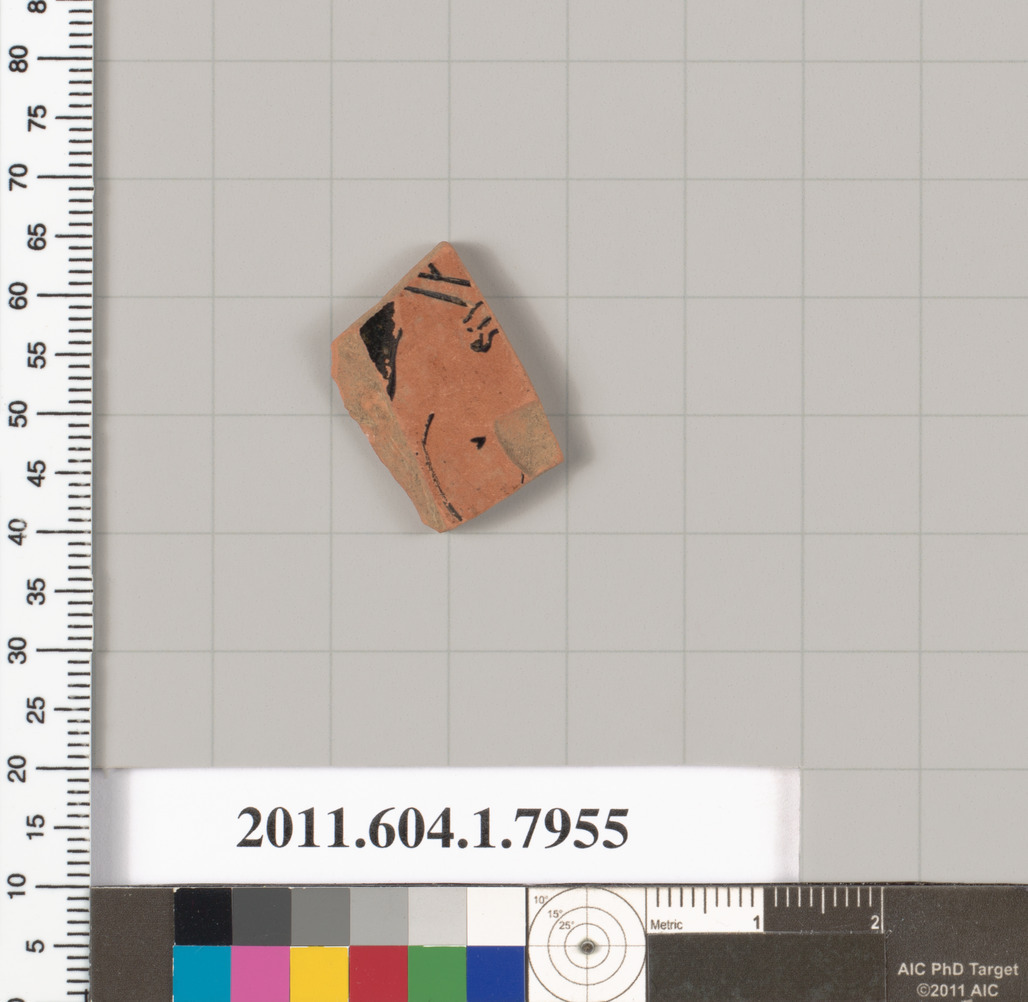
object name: kylix fragment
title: Terracotta fragment of a kylix (drinking cup)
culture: greek, attic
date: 460-450 BCE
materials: terracotta